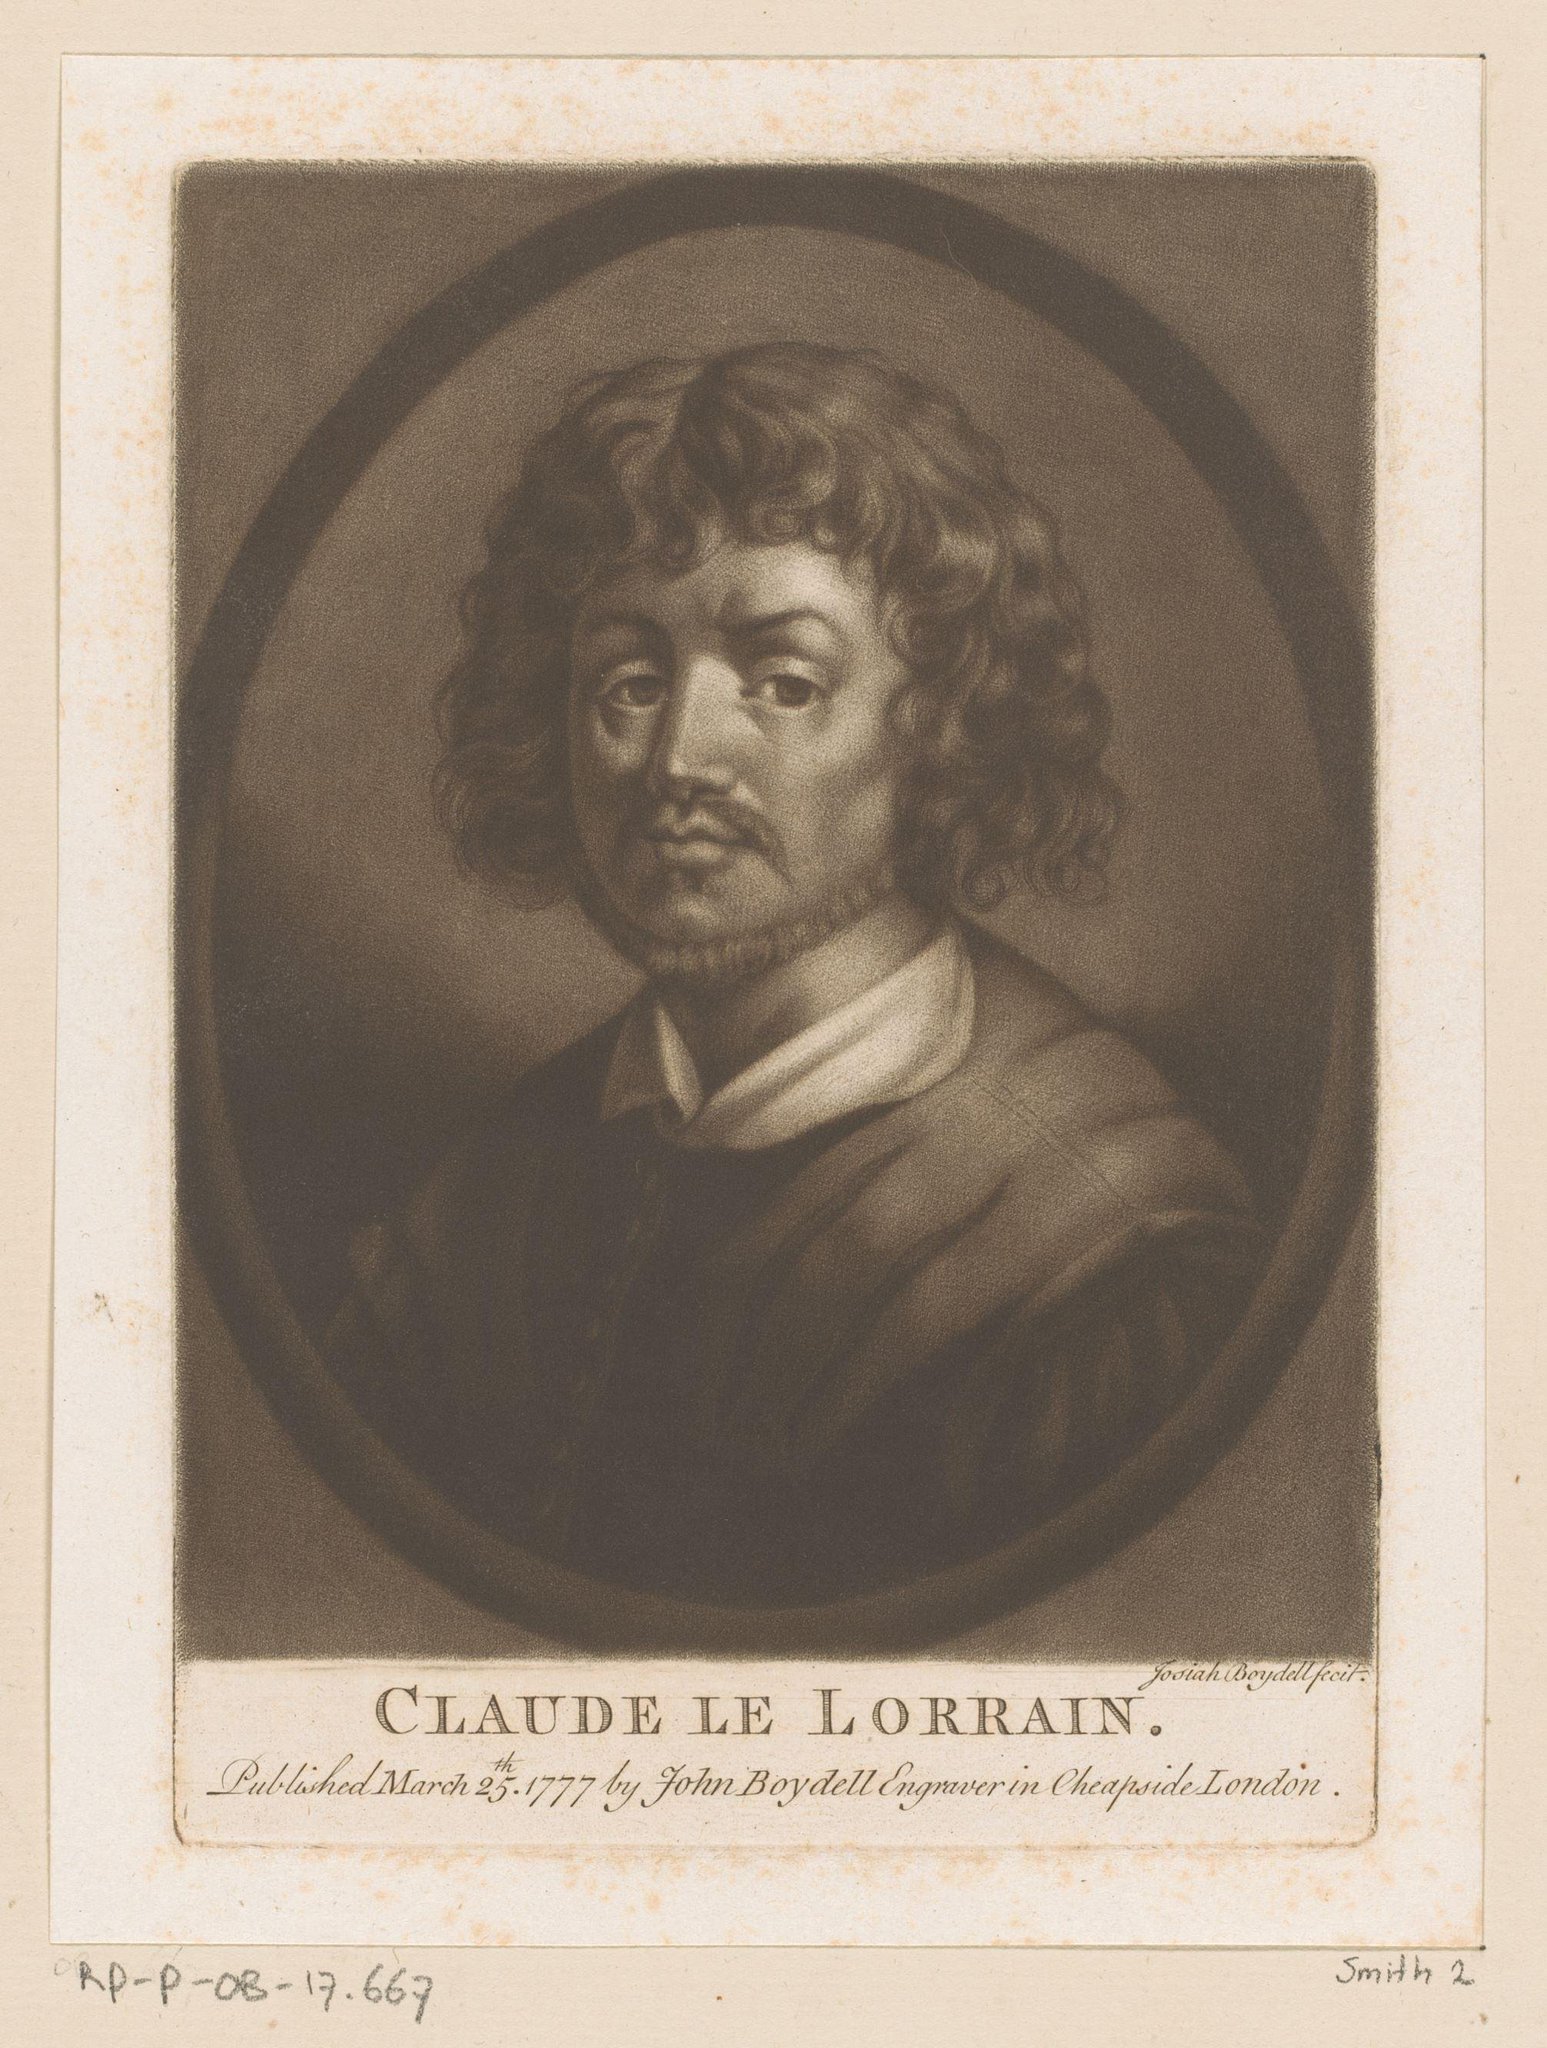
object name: print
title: Portret van Claude Lorrain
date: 1777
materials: paper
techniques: mezzotint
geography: london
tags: draughtsman, claude lorrain, historical persons, portrait, self-portrait of painter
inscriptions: date